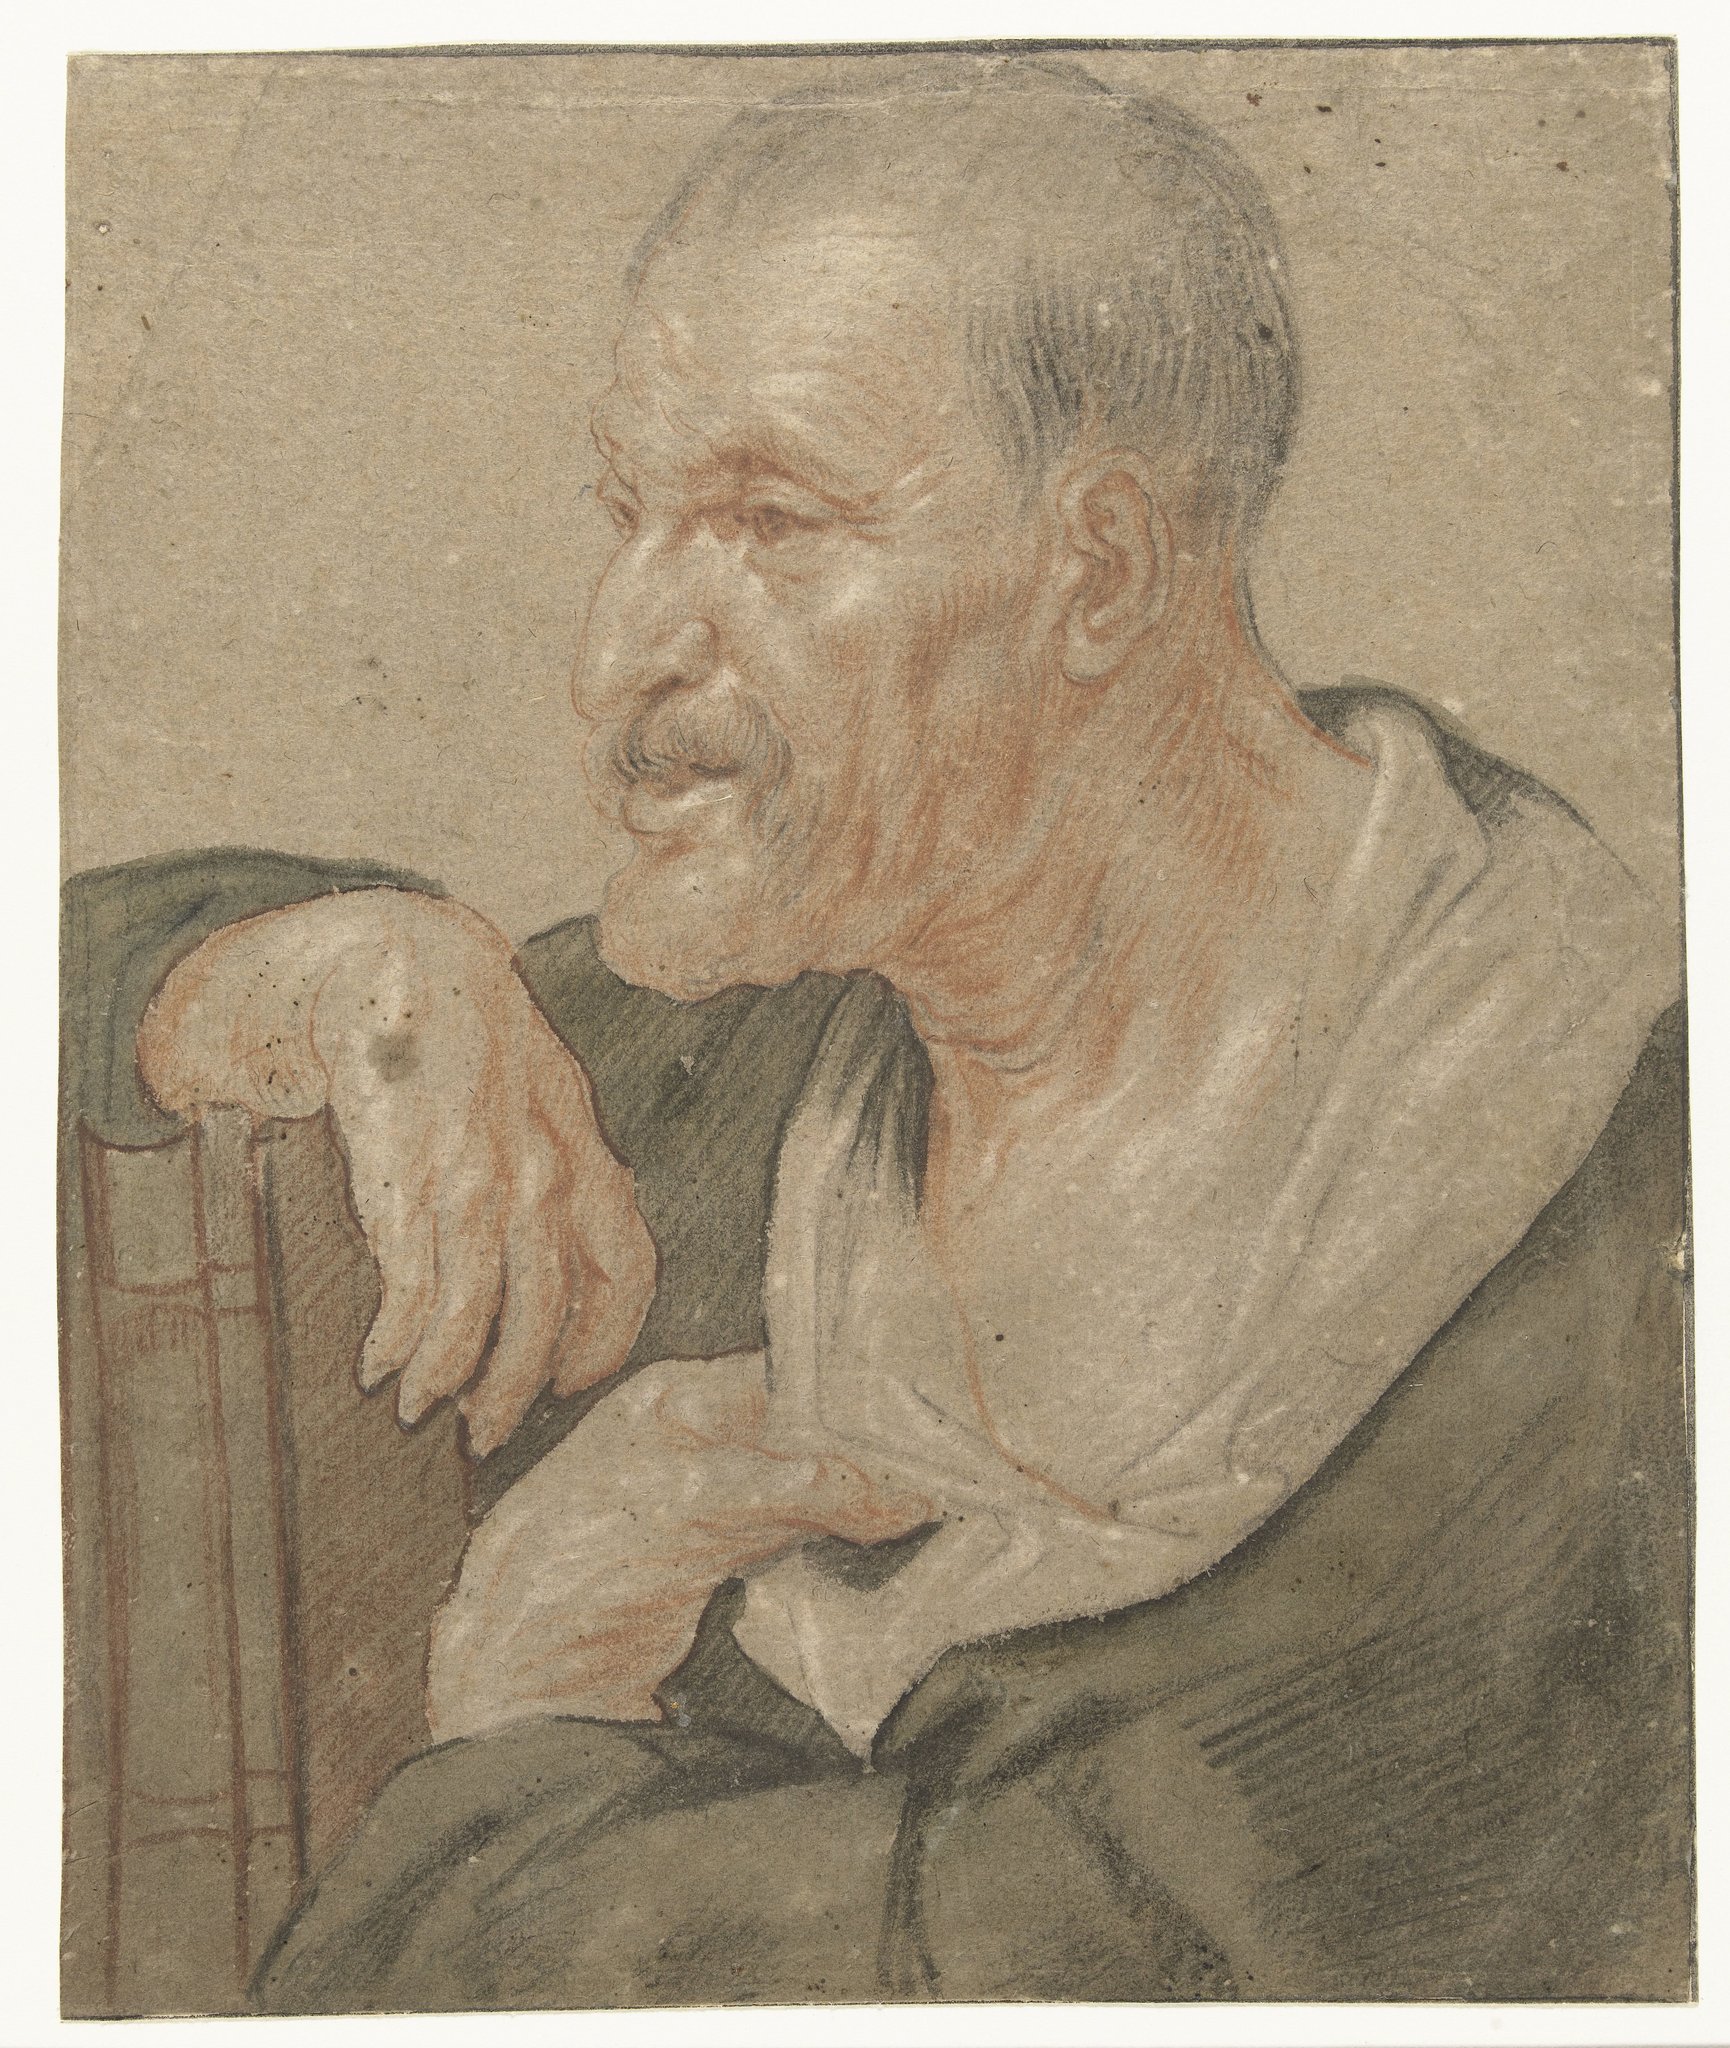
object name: drawing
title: Schouderstuk van een evangelist, naar links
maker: jacques jordaens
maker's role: designer, draughtsman, painter, print maker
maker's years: 1593-1678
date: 1603-1678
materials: chalk, paper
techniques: brush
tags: evangelists, usually with books or scrolls (not in biblical context), old man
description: Schouderstuk van een evangelist, leunend op een boek.